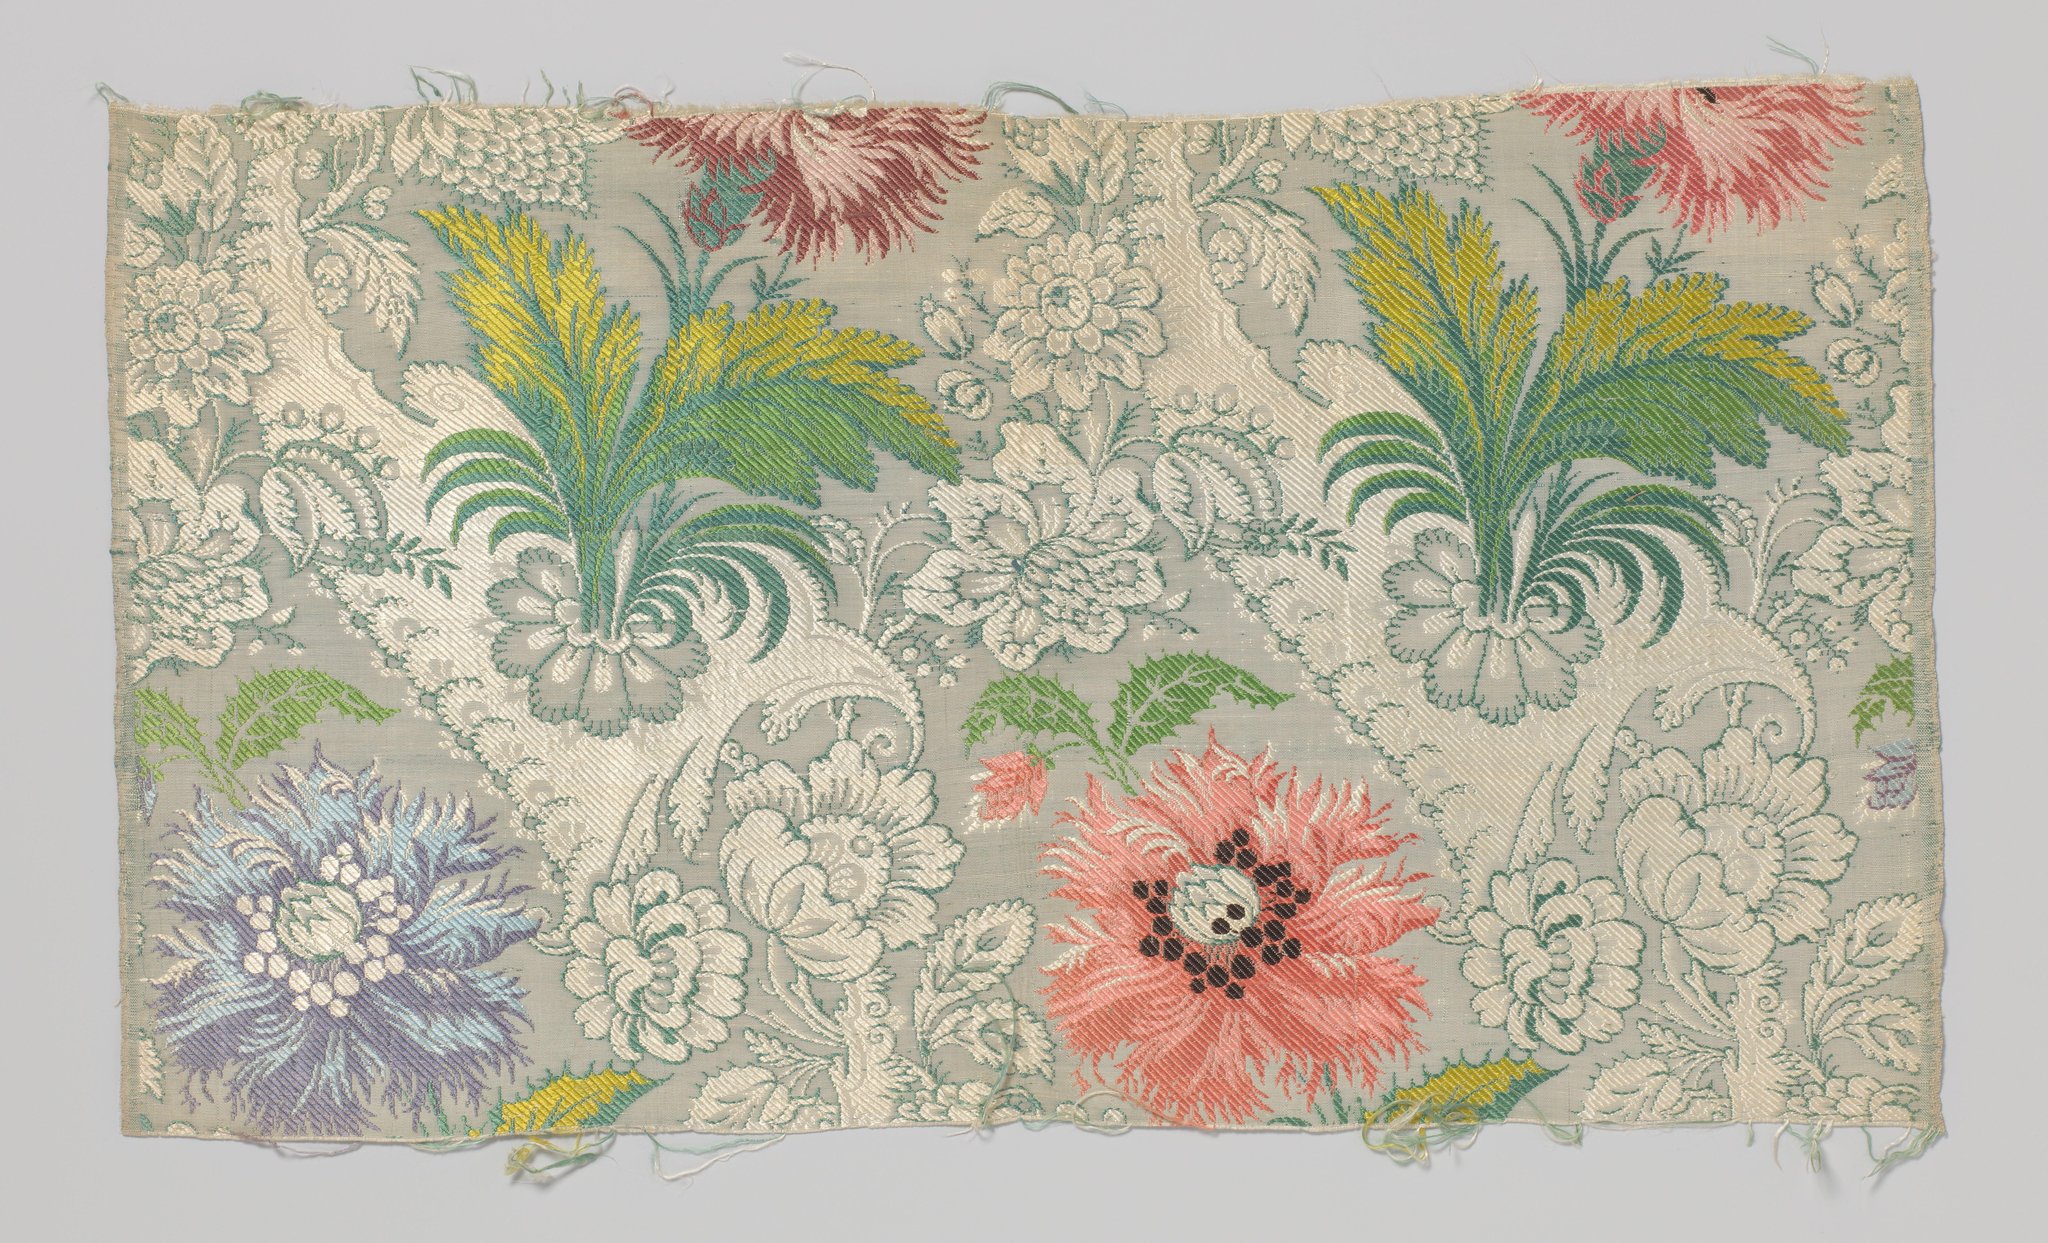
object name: fragment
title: Fragment gros de Tours met een patroon van veelkleurige anjers op grijsgroene grond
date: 1710-1730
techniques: brocade, weave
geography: france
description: Fragment gros de Tours. Patroon (onvolledig in de hoogte): asymmetrische rijen van naar rechts gewende anjers waarvan de toppen zijn afgesneden, wisselen af met rijen naar links gewende anjers waarvan de stengels zijn afgesneden. De anjers groeien op uit een wit V-vormig grondstuk met, rechts, uiteenspattende golven en links een regelmaat van schulpjes. De rechtse en langste arm van de V eindigt in een witte bloemtak, onder andere met rozen en druiventros (afgesneden). De anjerstelen ontspringen aan een uitgespaarde bladrozet, tezamen met een paar als pluimen uitwaaierende bladeren. De anjers zijn veelkleurig, op een grijsgroene grond.